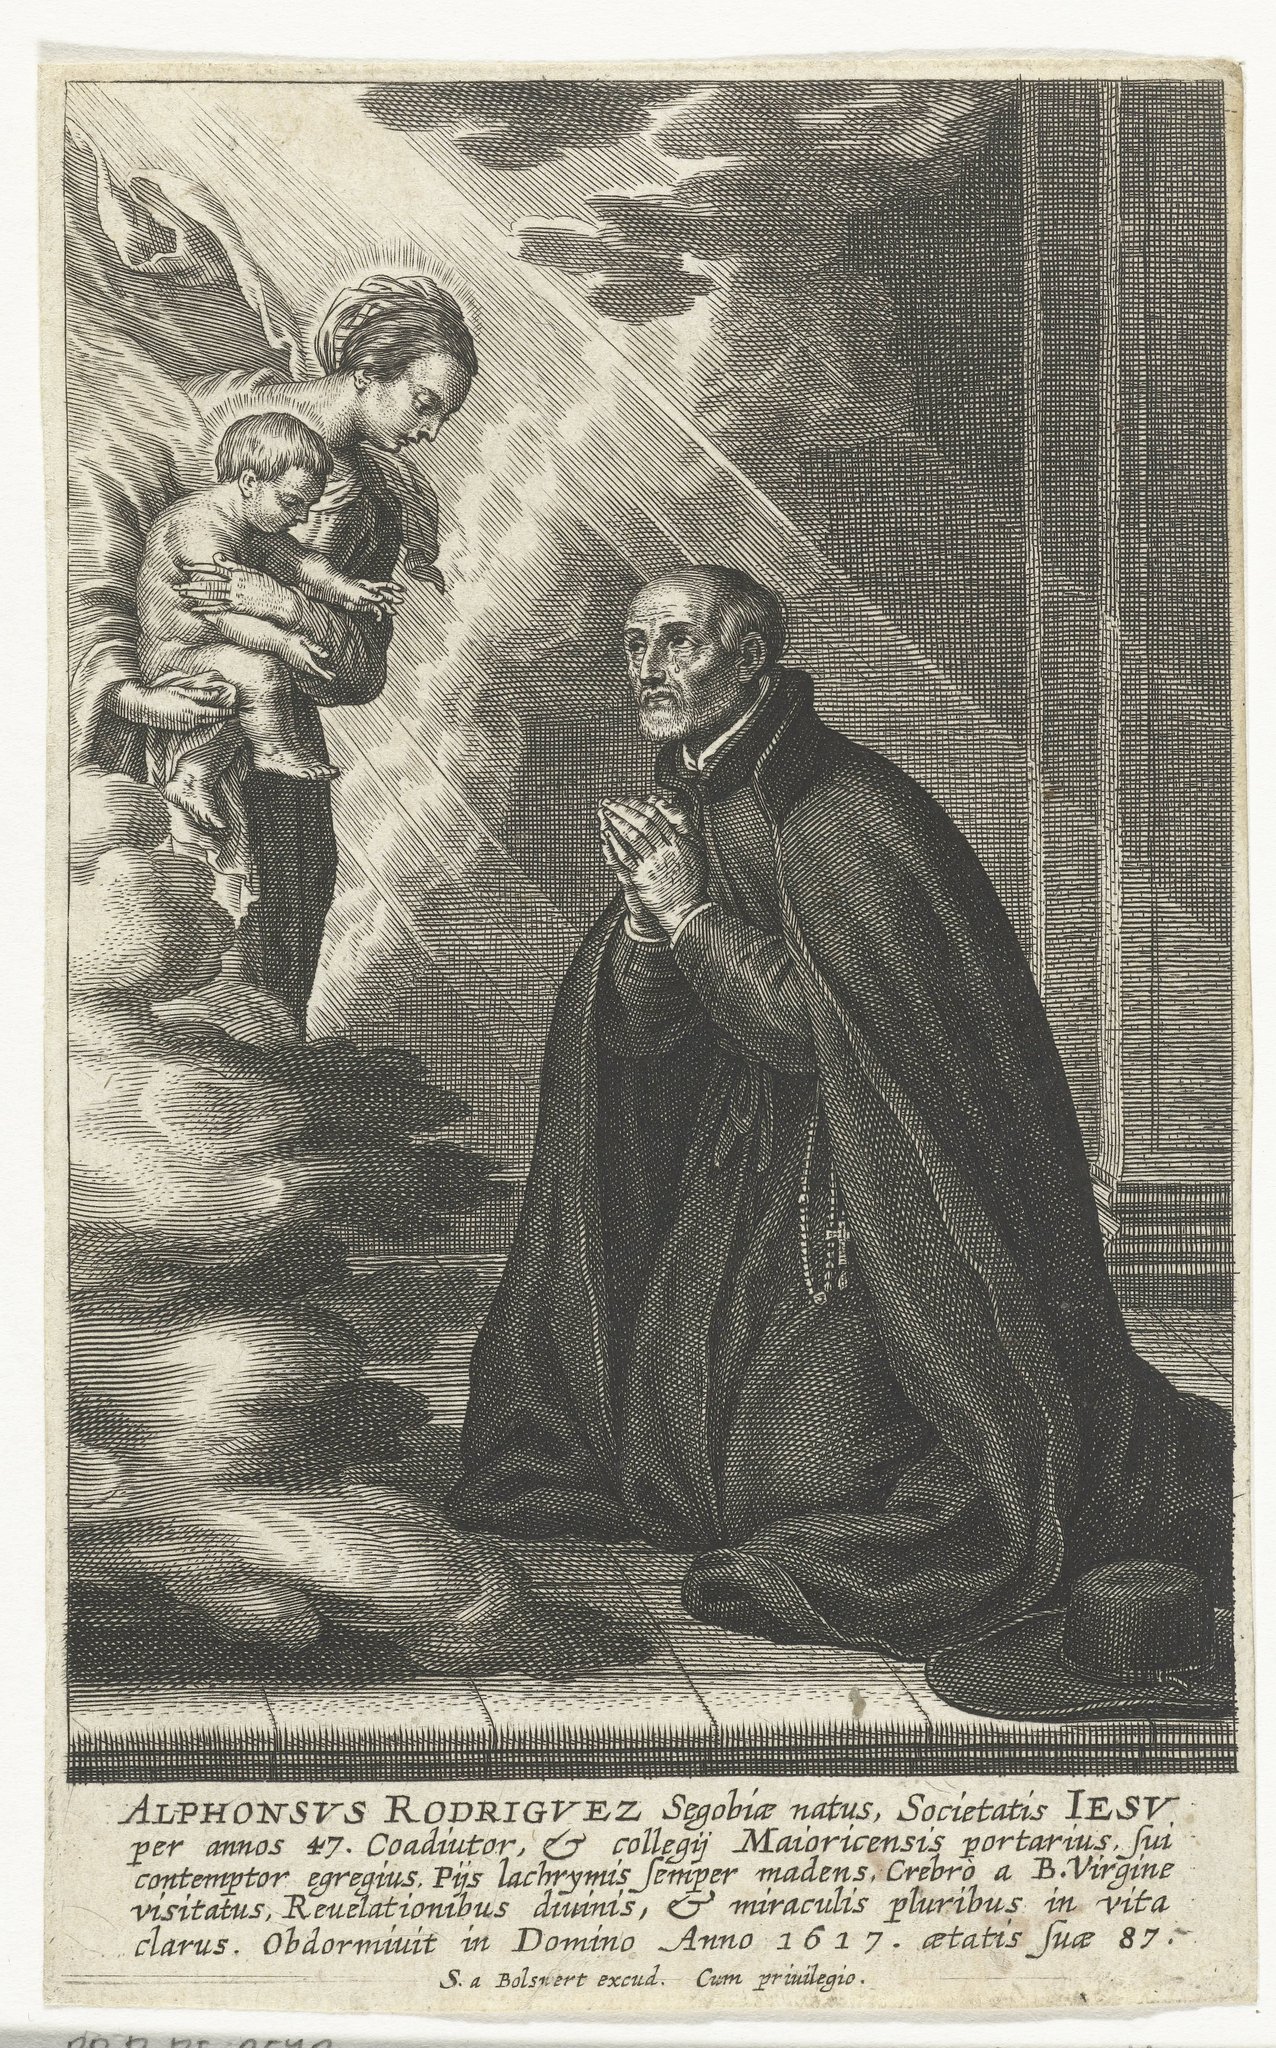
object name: print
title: Alphonsvs Rodrigvez segobiae (...) aetatis 87. Religionis 47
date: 1617-1659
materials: paper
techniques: engraving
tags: saints, madonna (i.e. mary with the christ-child) in the air, or on the clouds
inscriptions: collector's mark: Lugt 240